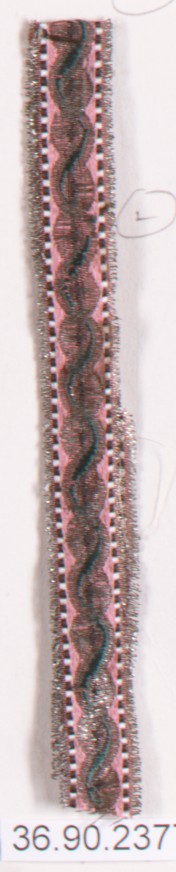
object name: ribbon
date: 1801-1900